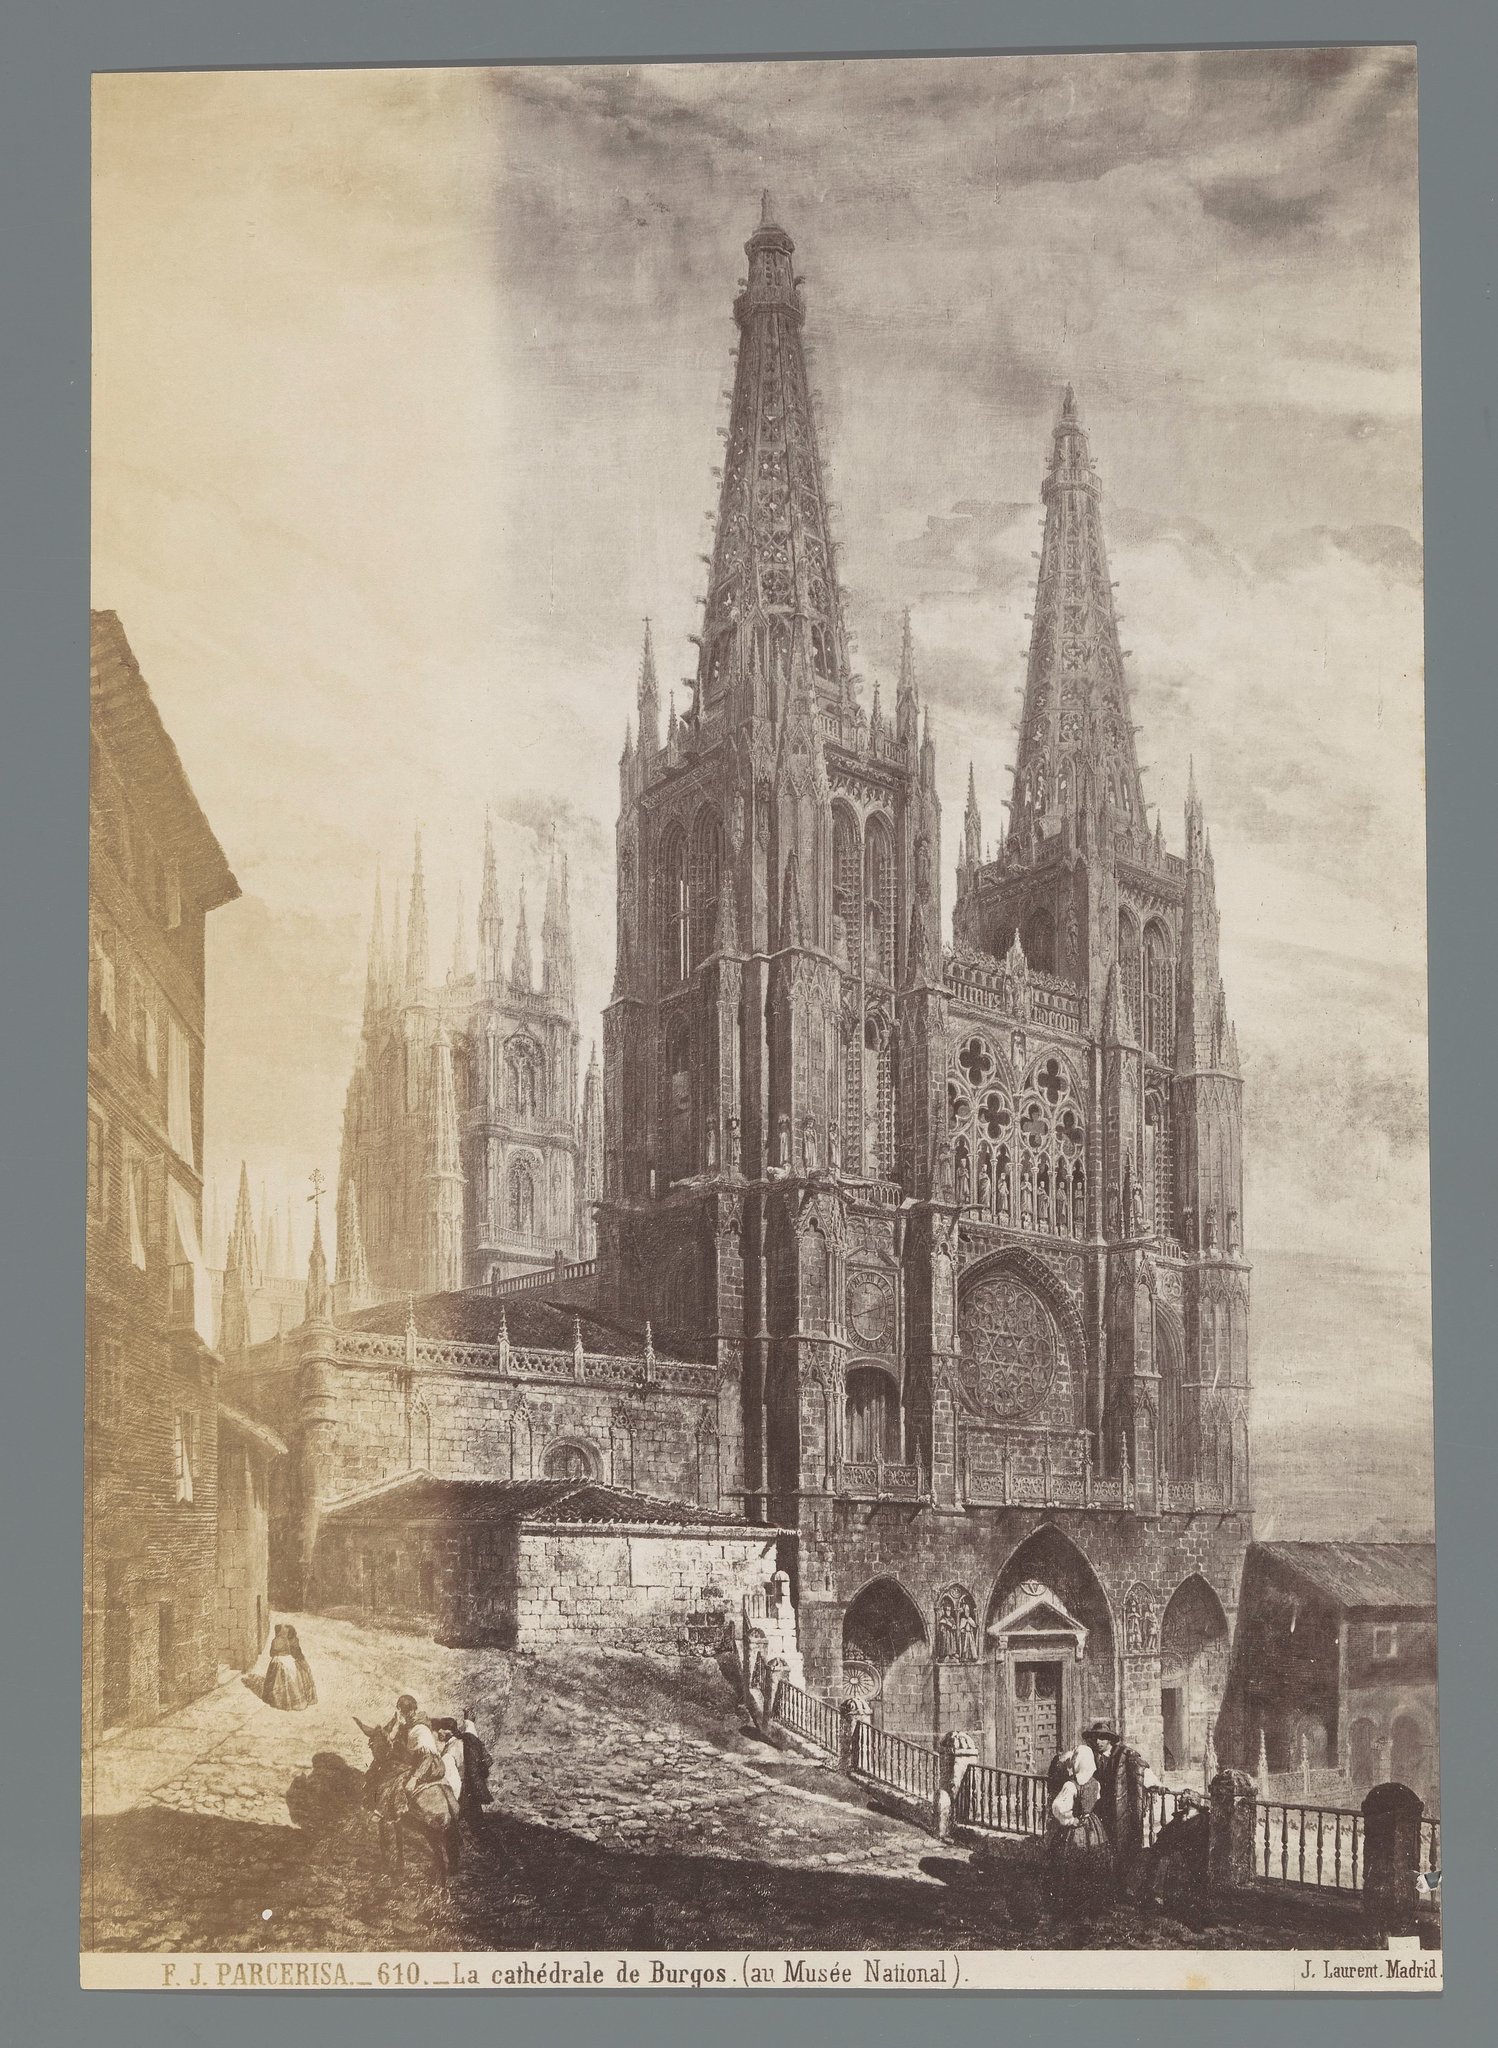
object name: album leaf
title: F. J. Parcerisa, la cathédrale de Burgos (au Musée National)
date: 1856-1863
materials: paper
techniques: albumen print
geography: madrid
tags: church (exterior)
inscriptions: number: ‘610.’